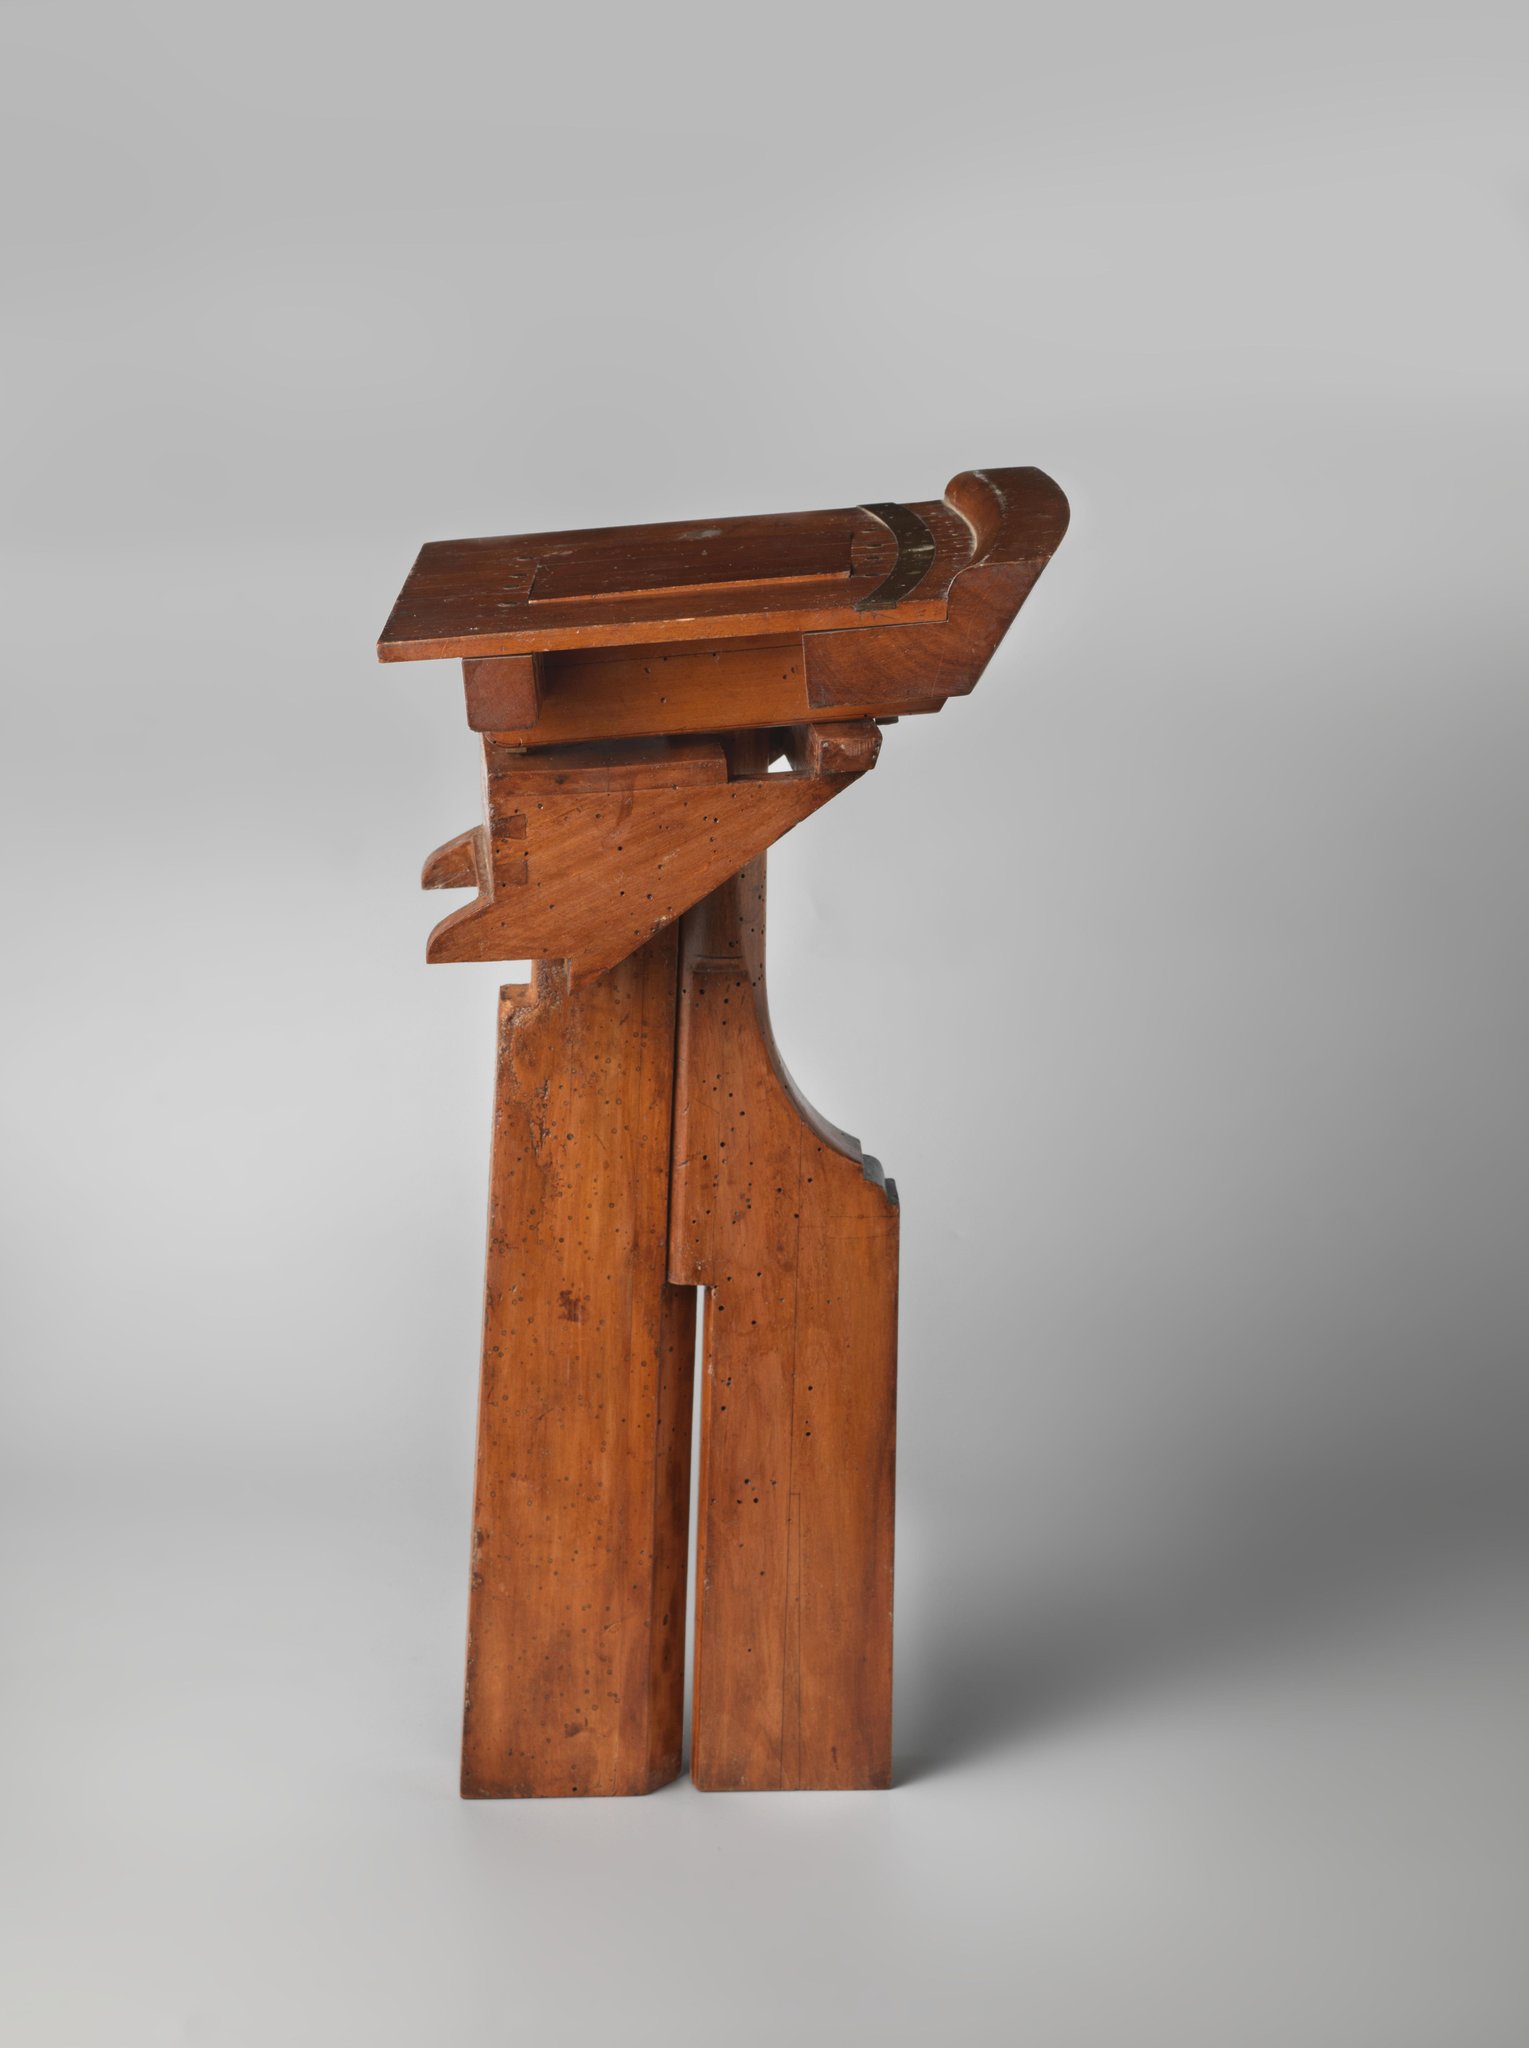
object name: demonstration model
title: Model of a Round-Headed Rudder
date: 1829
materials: wood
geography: netherlands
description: Model van het bovenstuk van een roer met achtersteven en wulfconstructie, in slechte staat. De roerkop springt naar voren en is rond. De messing van het roer is afgerond, die van de achtersteven is scherp onderaan, maar wordt hol waar de roerkop begint. Het voornaamste voordeel van dit roer was de afsluiting van het hennegat door de toepassing van een ronde roerkoning.